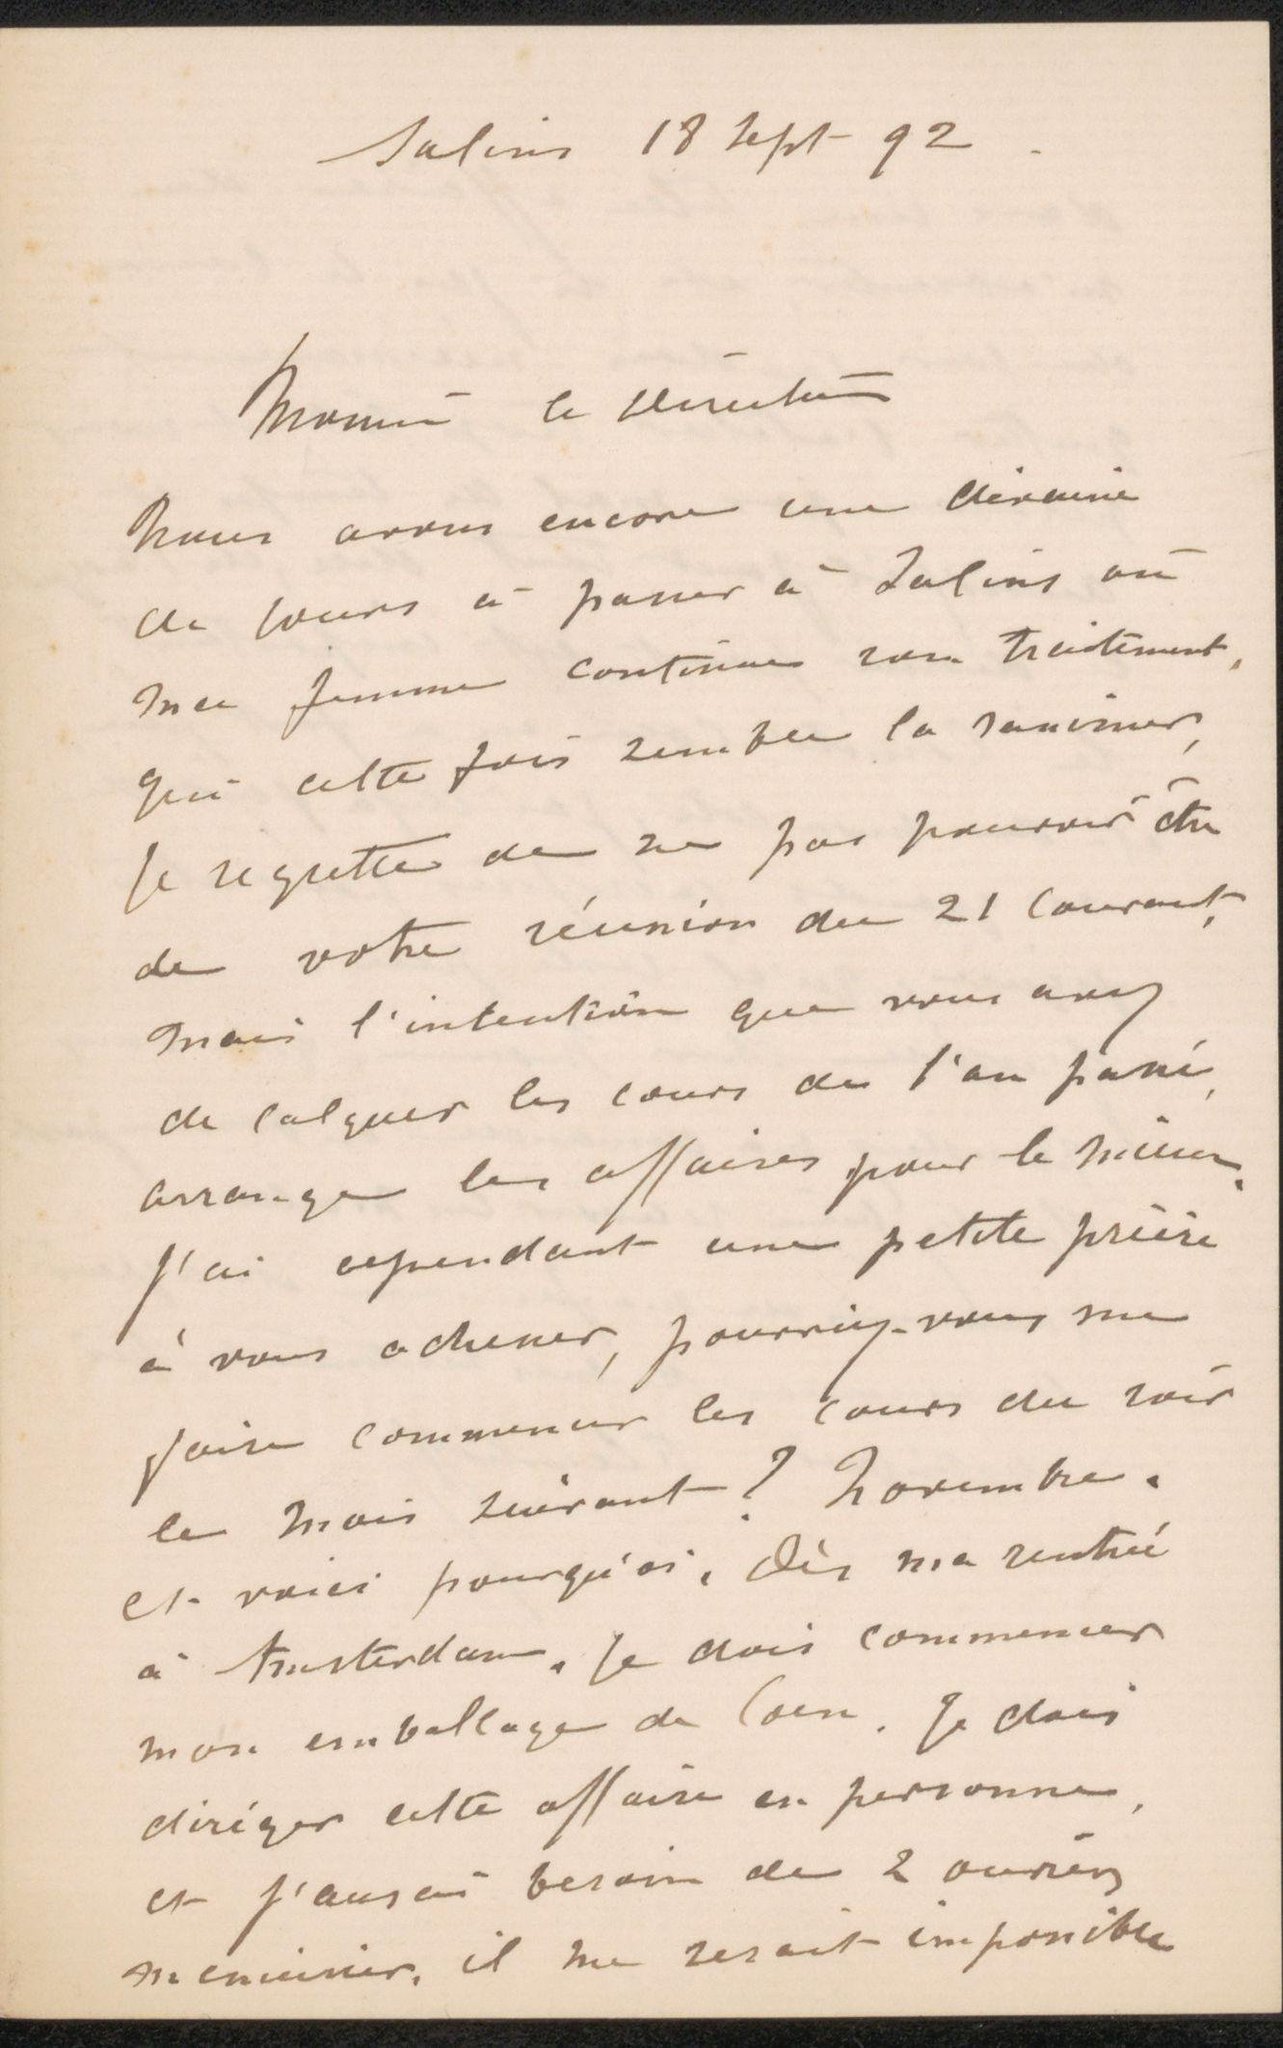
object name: letter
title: Brief aan August Allebé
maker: ferdinand leenhoff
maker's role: print maker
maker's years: 1841-1914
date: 1892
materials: ink, paper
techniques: pen, writing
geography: salins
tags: august allebé, batavia, sculpture, historical persons (portraits and scenes from the life), amsterdam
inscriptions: watermark